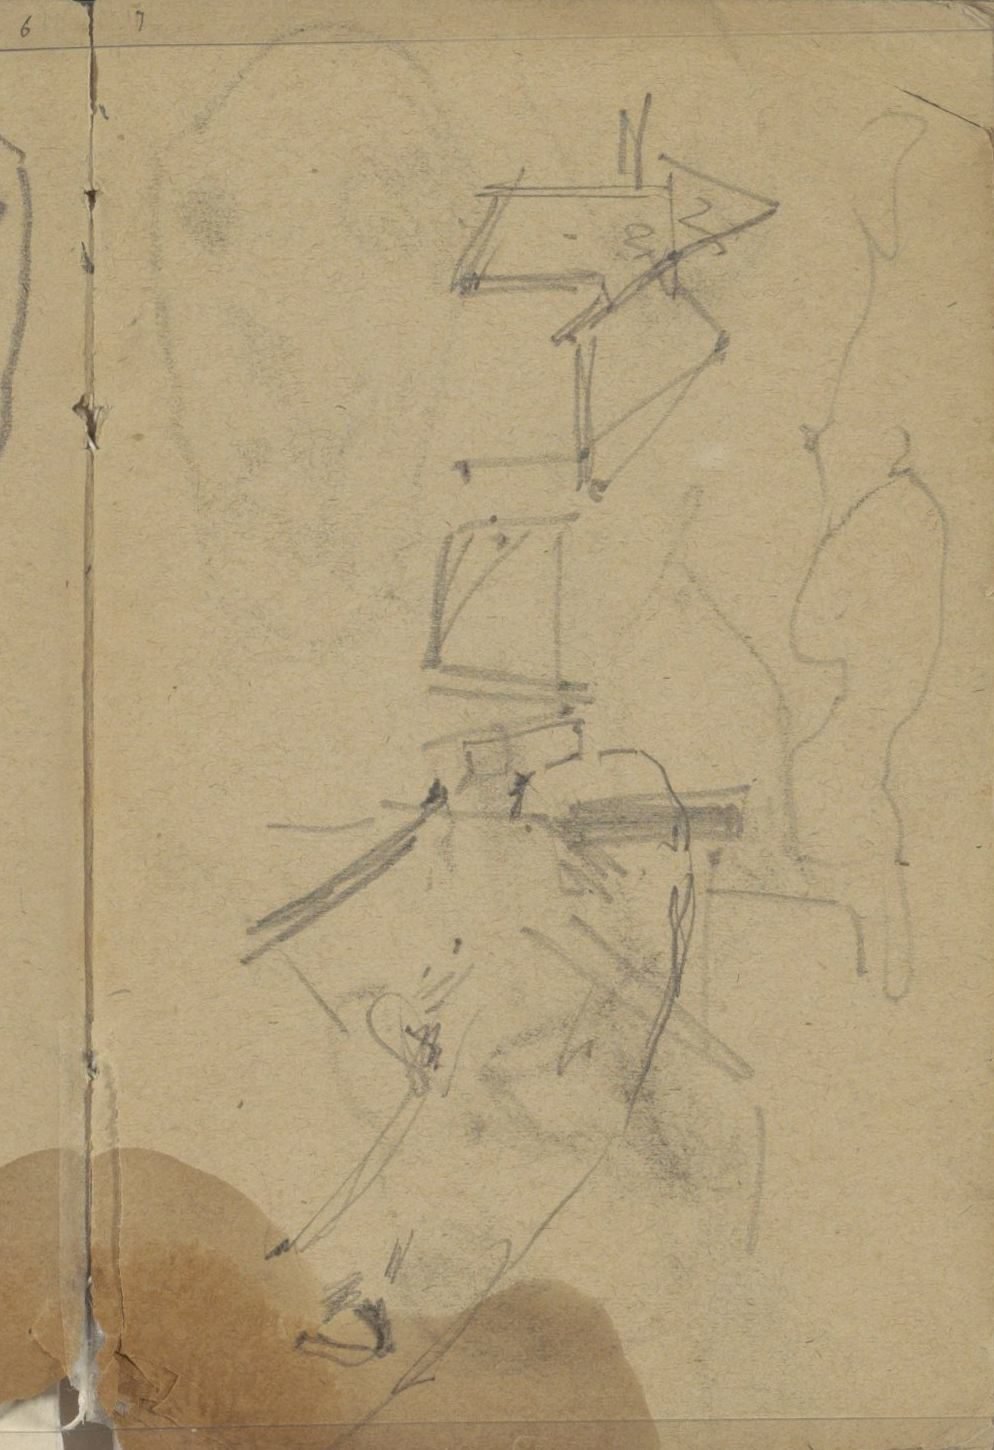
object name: sketchbook leaf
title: Landschap met bebouwing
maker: george hendrik breitner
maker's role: draughtsman, painter, print maker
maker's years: 1857-1923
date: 1881-1883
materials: paper, pencil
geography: south holland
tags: landscapes, civic architecture; edifices; dwellings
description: Landschap met bebouwing. Pagina 7 uit een schetsboek met 70 bladen.